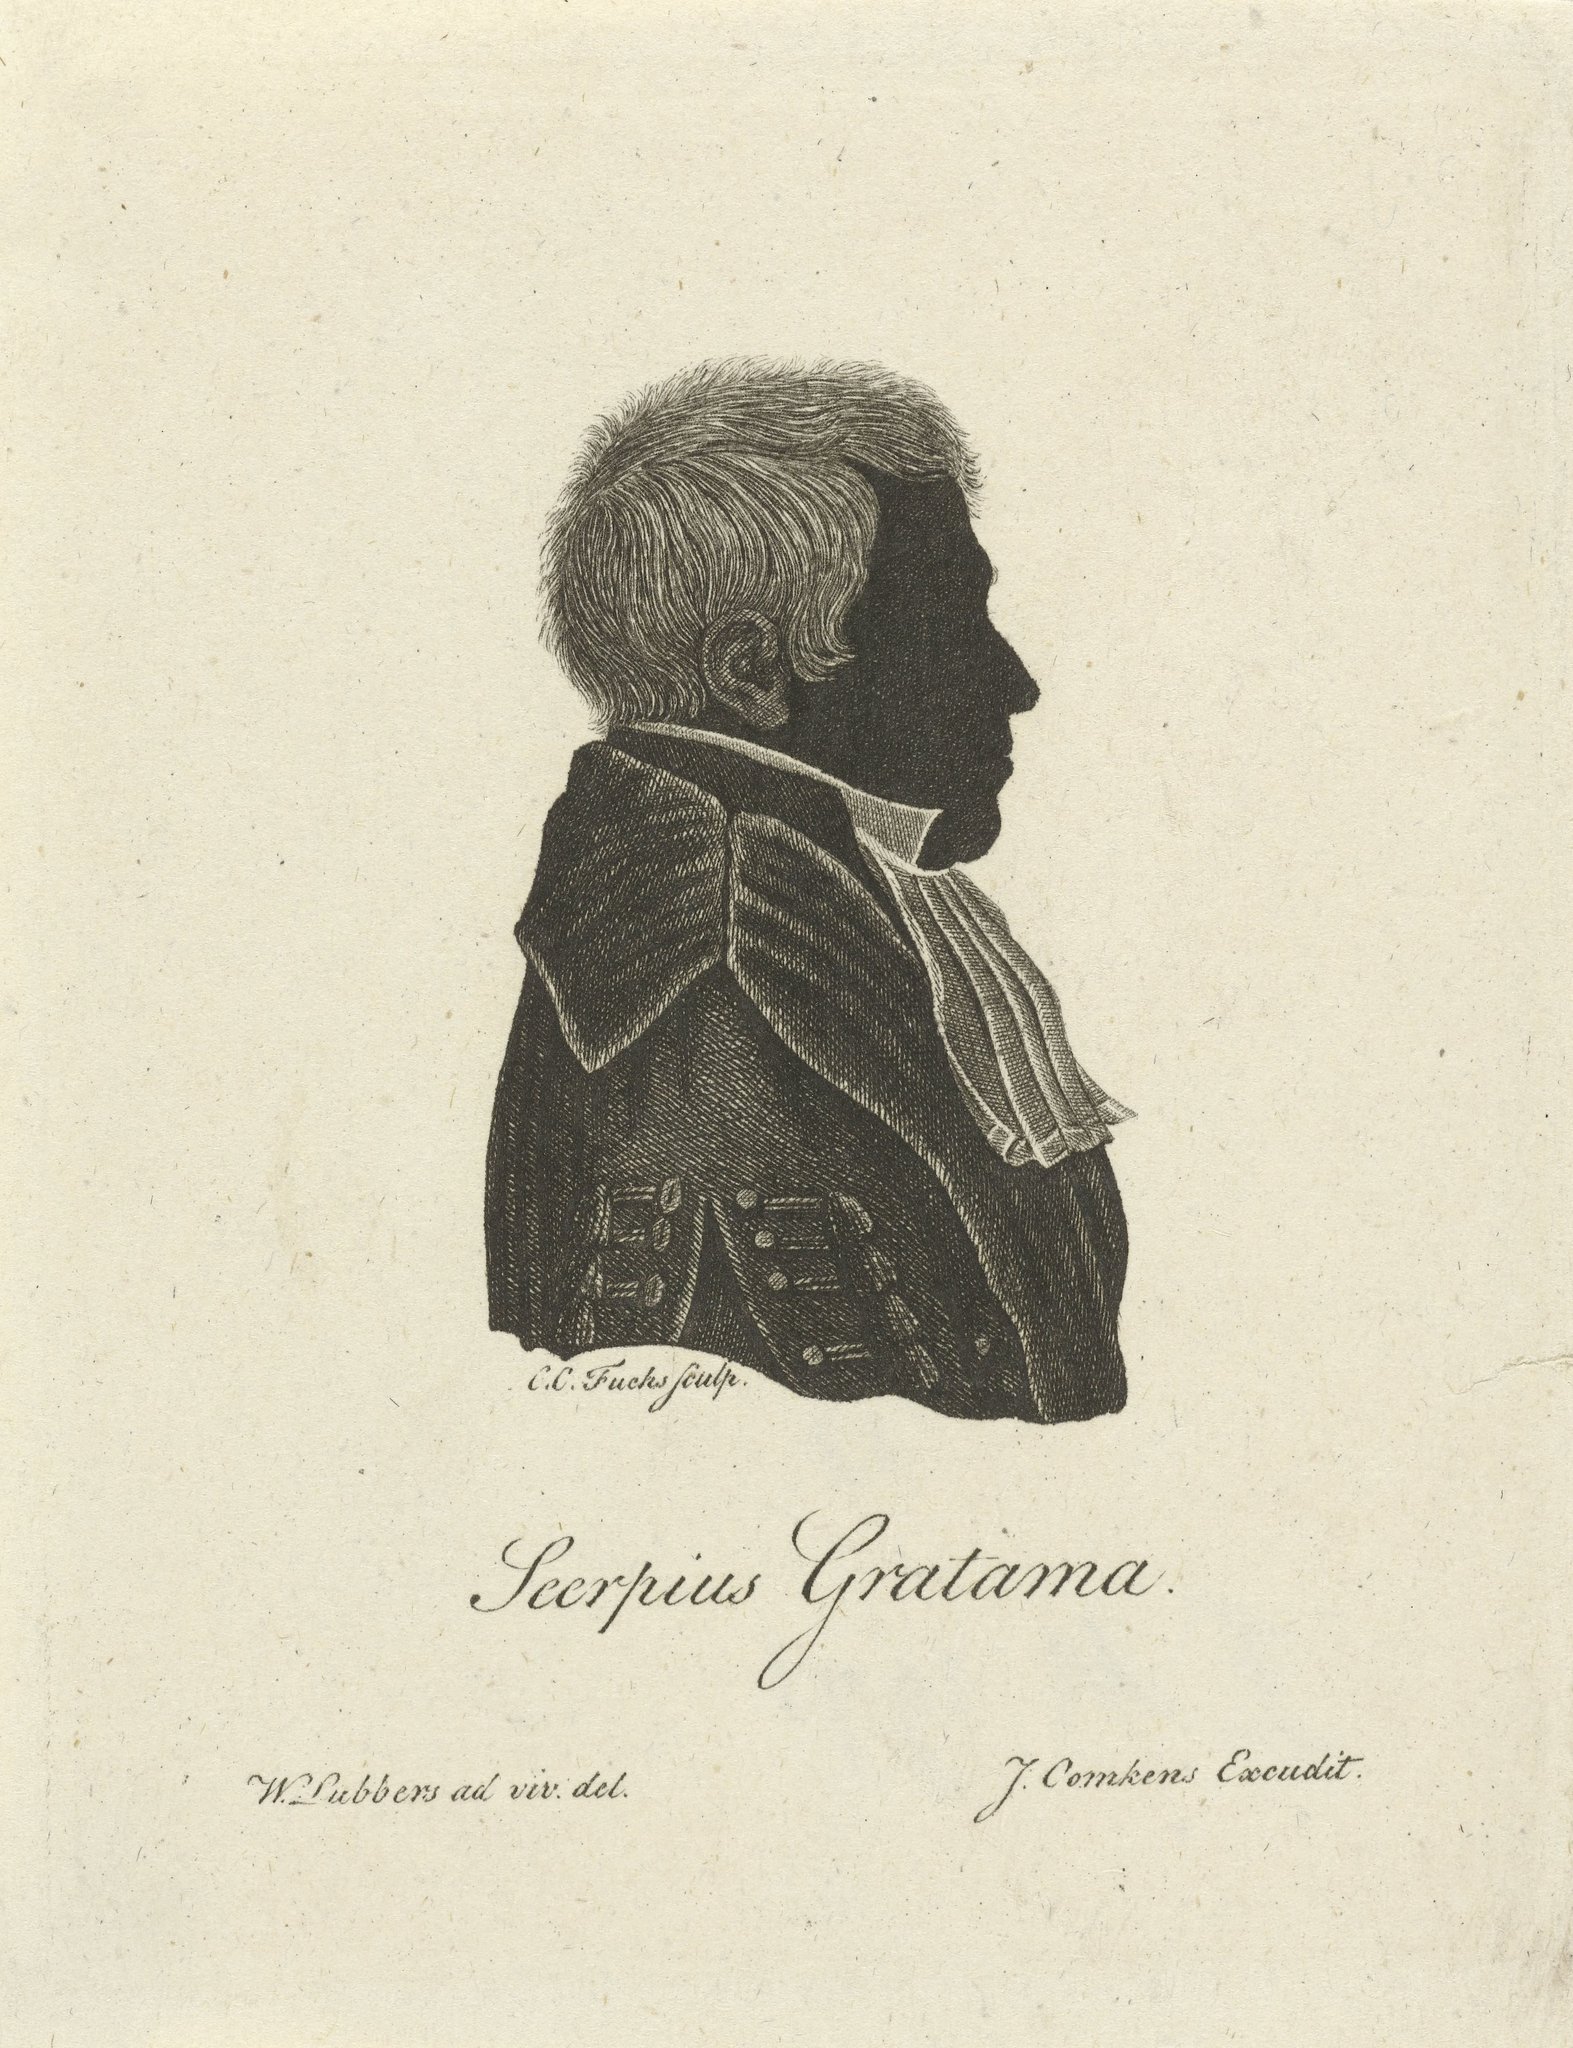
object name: print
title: Silhouetportret van Seerp Gratama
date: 1808-1844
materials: paper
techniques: etching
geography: groningen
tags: harlingen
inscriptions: collector's mark: Lugt 2228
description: Silhouetportret van Seerp Gratama, buste naar rechts.